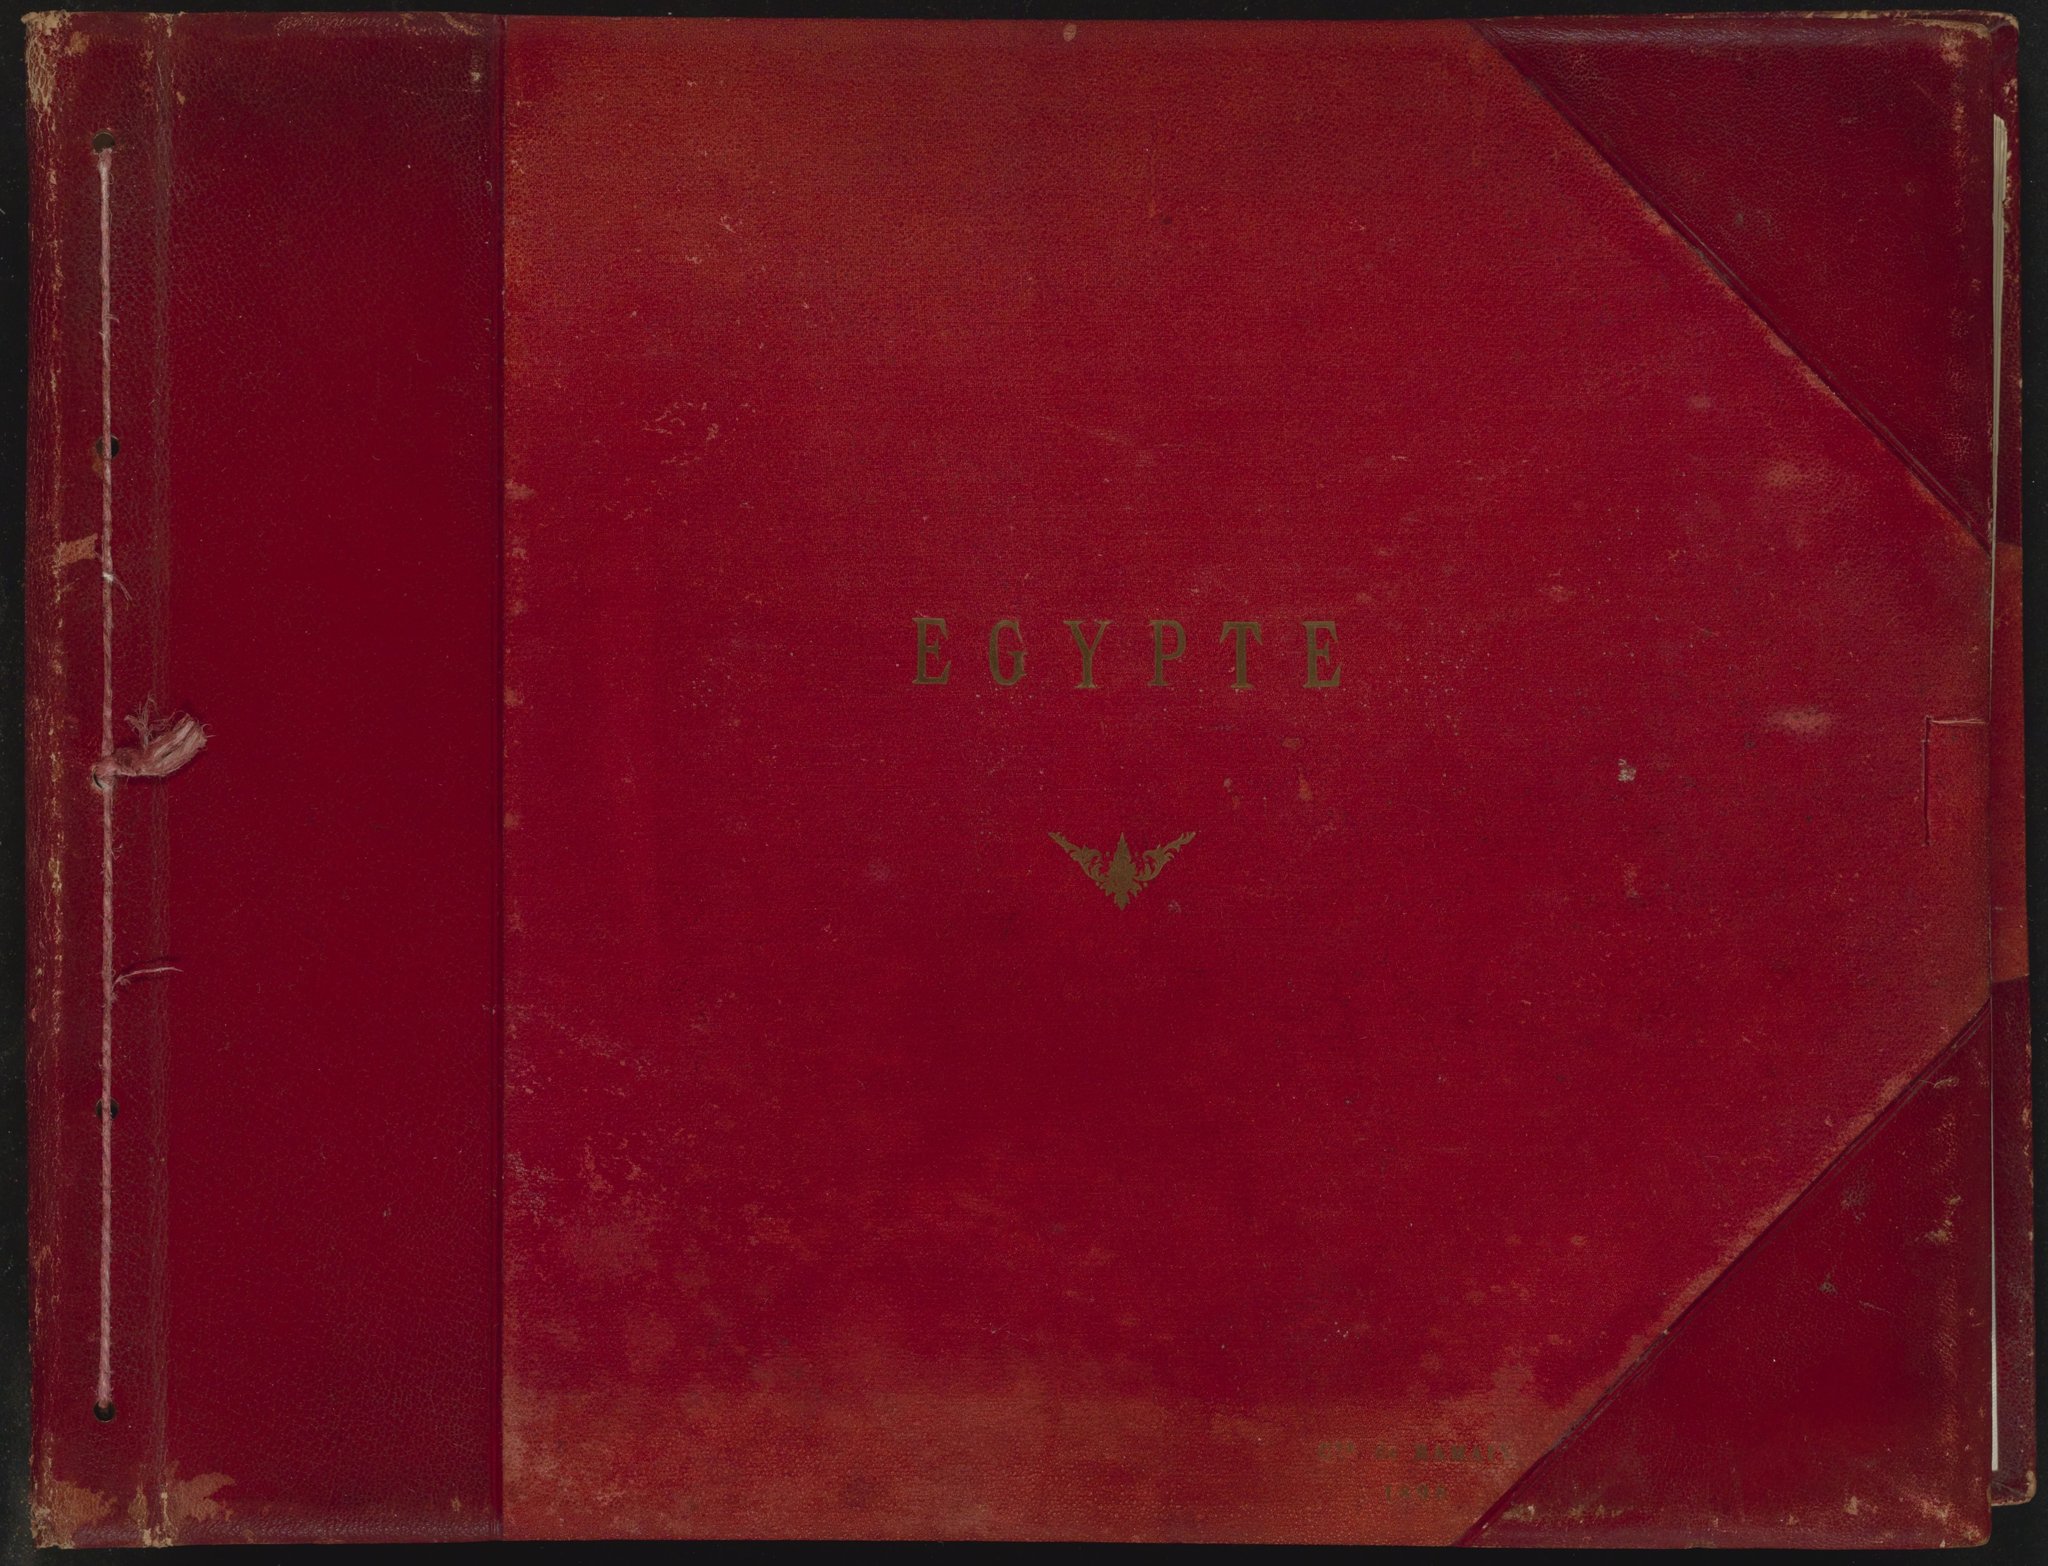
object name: photograph album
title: Egypte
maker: cte. de ramaix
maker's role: fotograaf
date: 1898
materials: cardboard, leather, paper, photographic support, textile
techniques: albumen print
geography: belgium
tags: landscape with ruins, travelling; tourism, ruin of a dwelling, house, castle, etc.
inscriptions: inscription: ‘Cte. de RAMAIX 1898’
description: Fotoalbum in rood omslag met leren rug en hoekpunten. De bandrug is doorregen met een rood koord. De schutbladen zijn van changeant papier. Het album bevat tachtig kartonnen bladen met daarop evenzoveel foto's. Het betreft voornamelijk opnames van bouwwerken uit het Oude Egypte: tempels, piramides, kolossen, sfinxen, zuilengalerijen en standbeelden. Ook dorps- en riviergezichten. Mogelijk is de samensteller graaf Maurice de Ramaix, een Belgische diplomaat die werkzaam was in onder meer Perzië en het Ottomaanse Rijk.